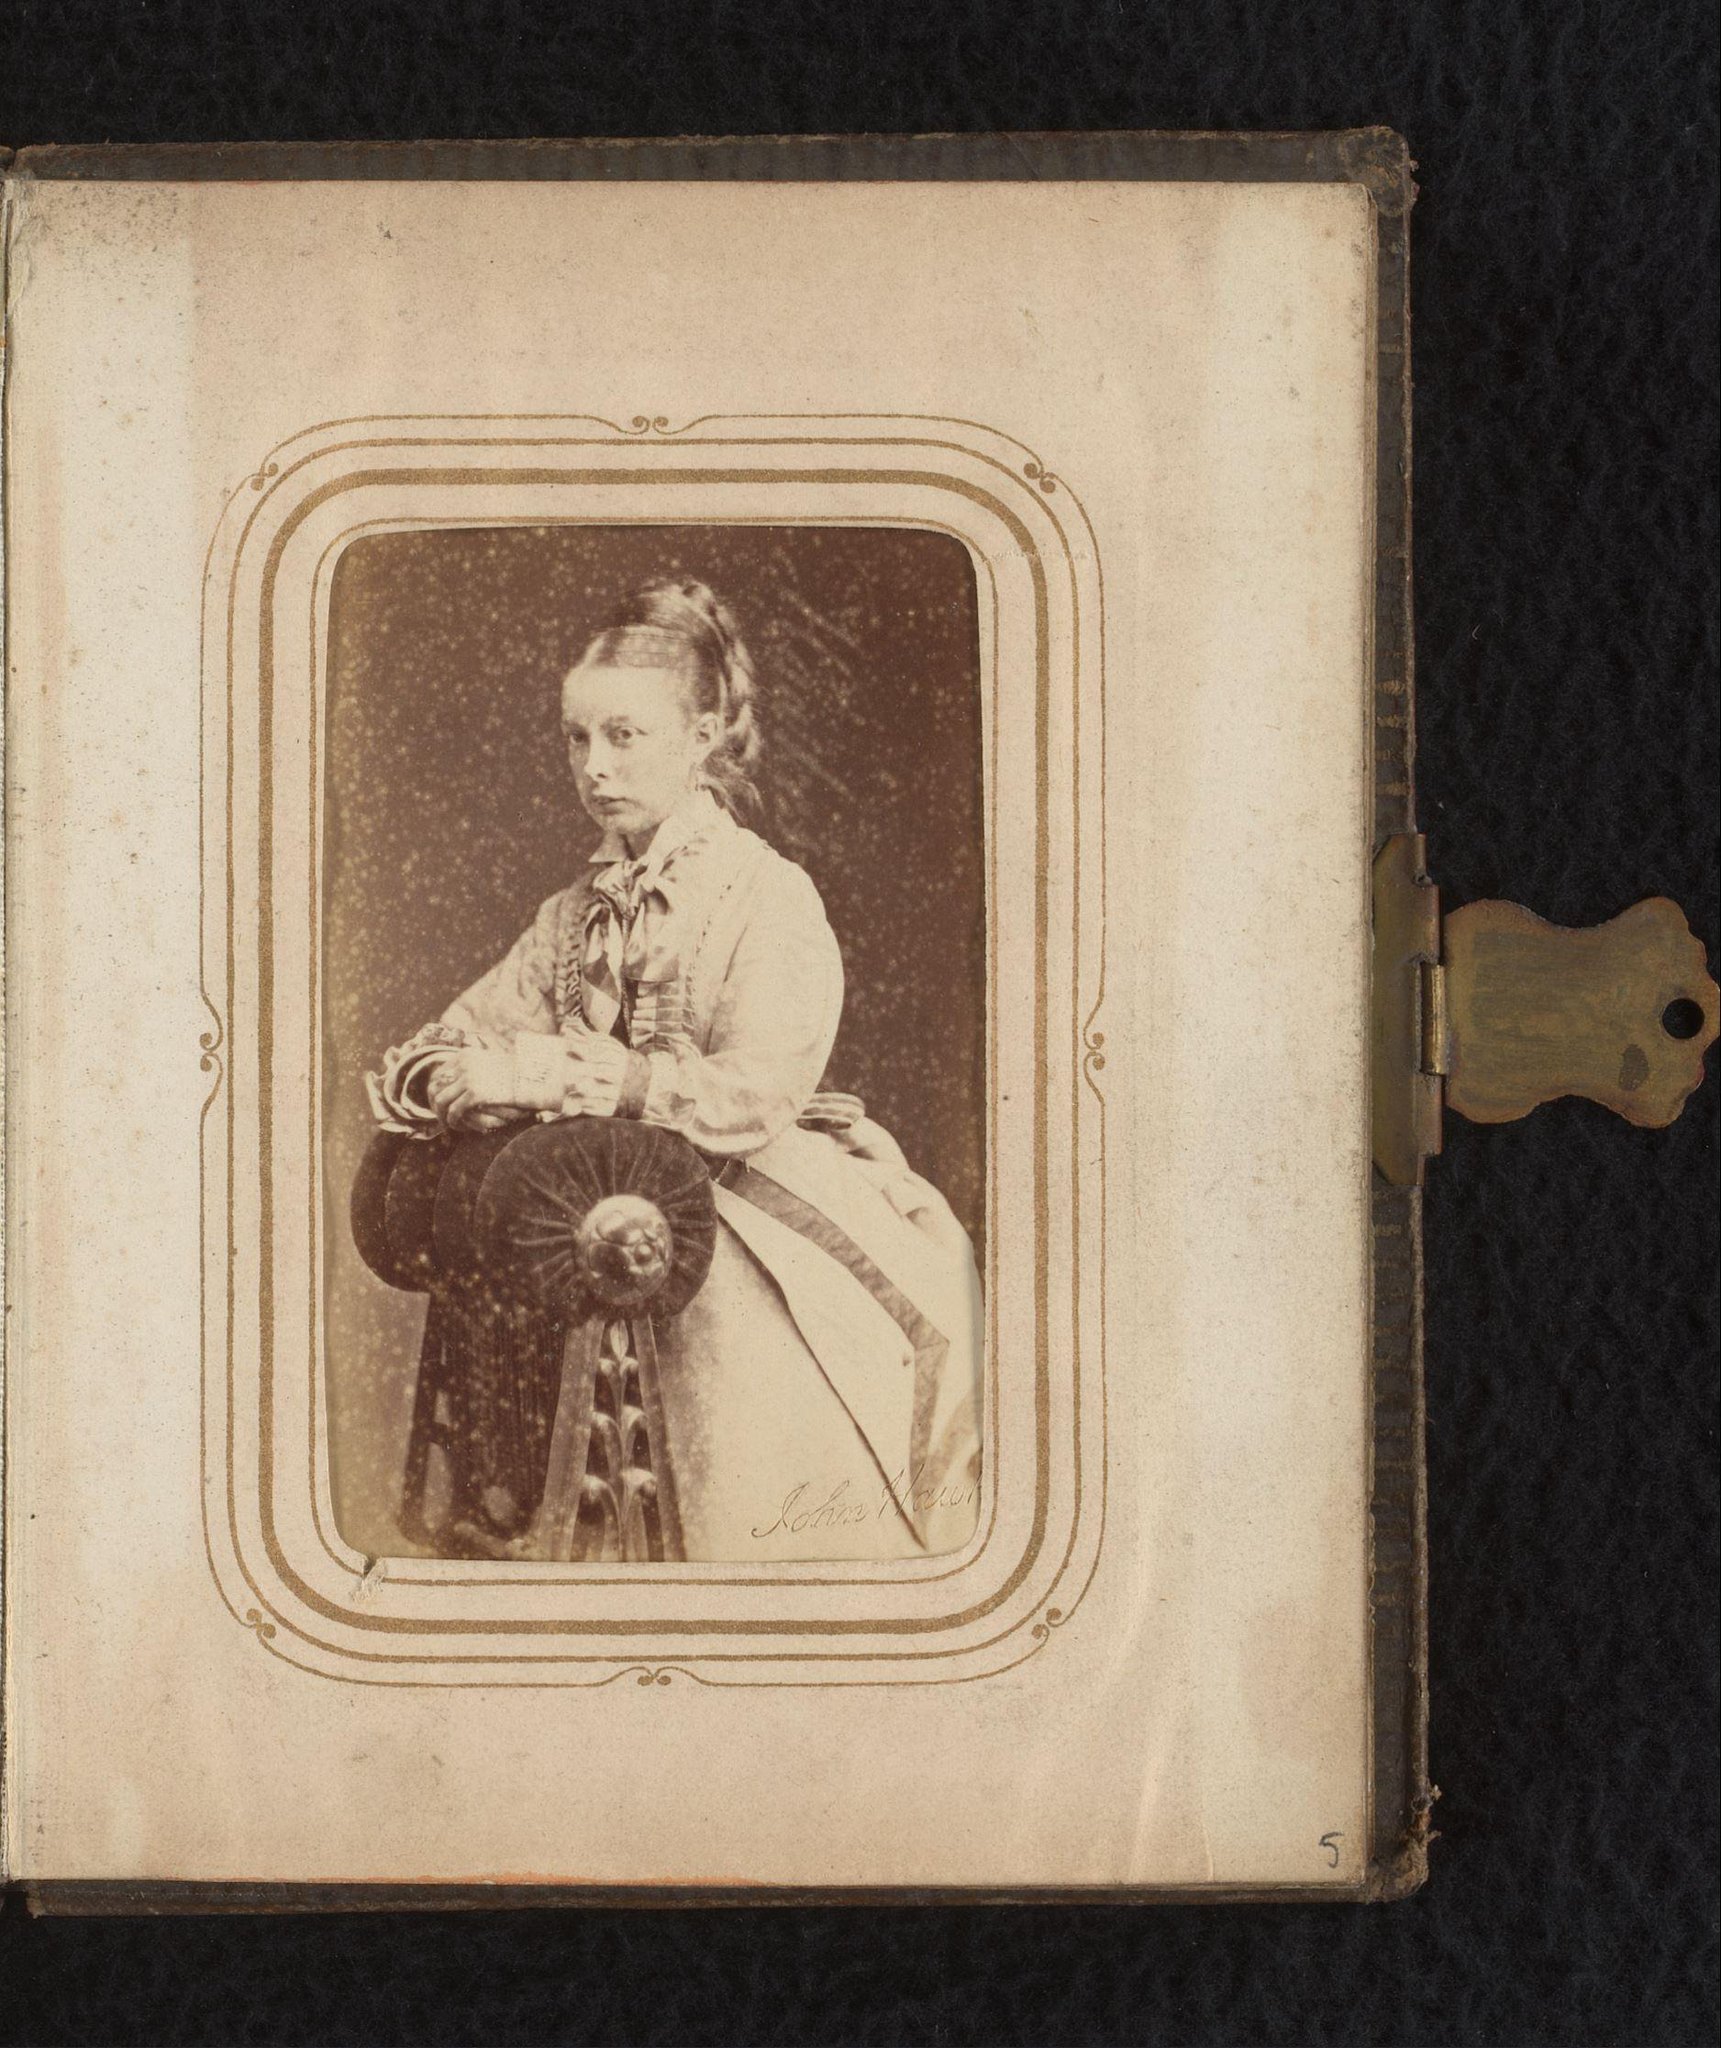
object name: photograph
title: Portret van een jonge vrouw, aangeduid als Ellie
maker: john hawke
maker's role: fotograaf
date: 1860-1900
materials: cardboard, photographic support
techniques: albumen print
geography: plymouth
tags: adolescent, young woman, maiden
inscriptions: inscription: ‘John Hawke’, annotation: ‘29698/ Ellie [...]’, inscription: ‘Hawke/ Plymouth’